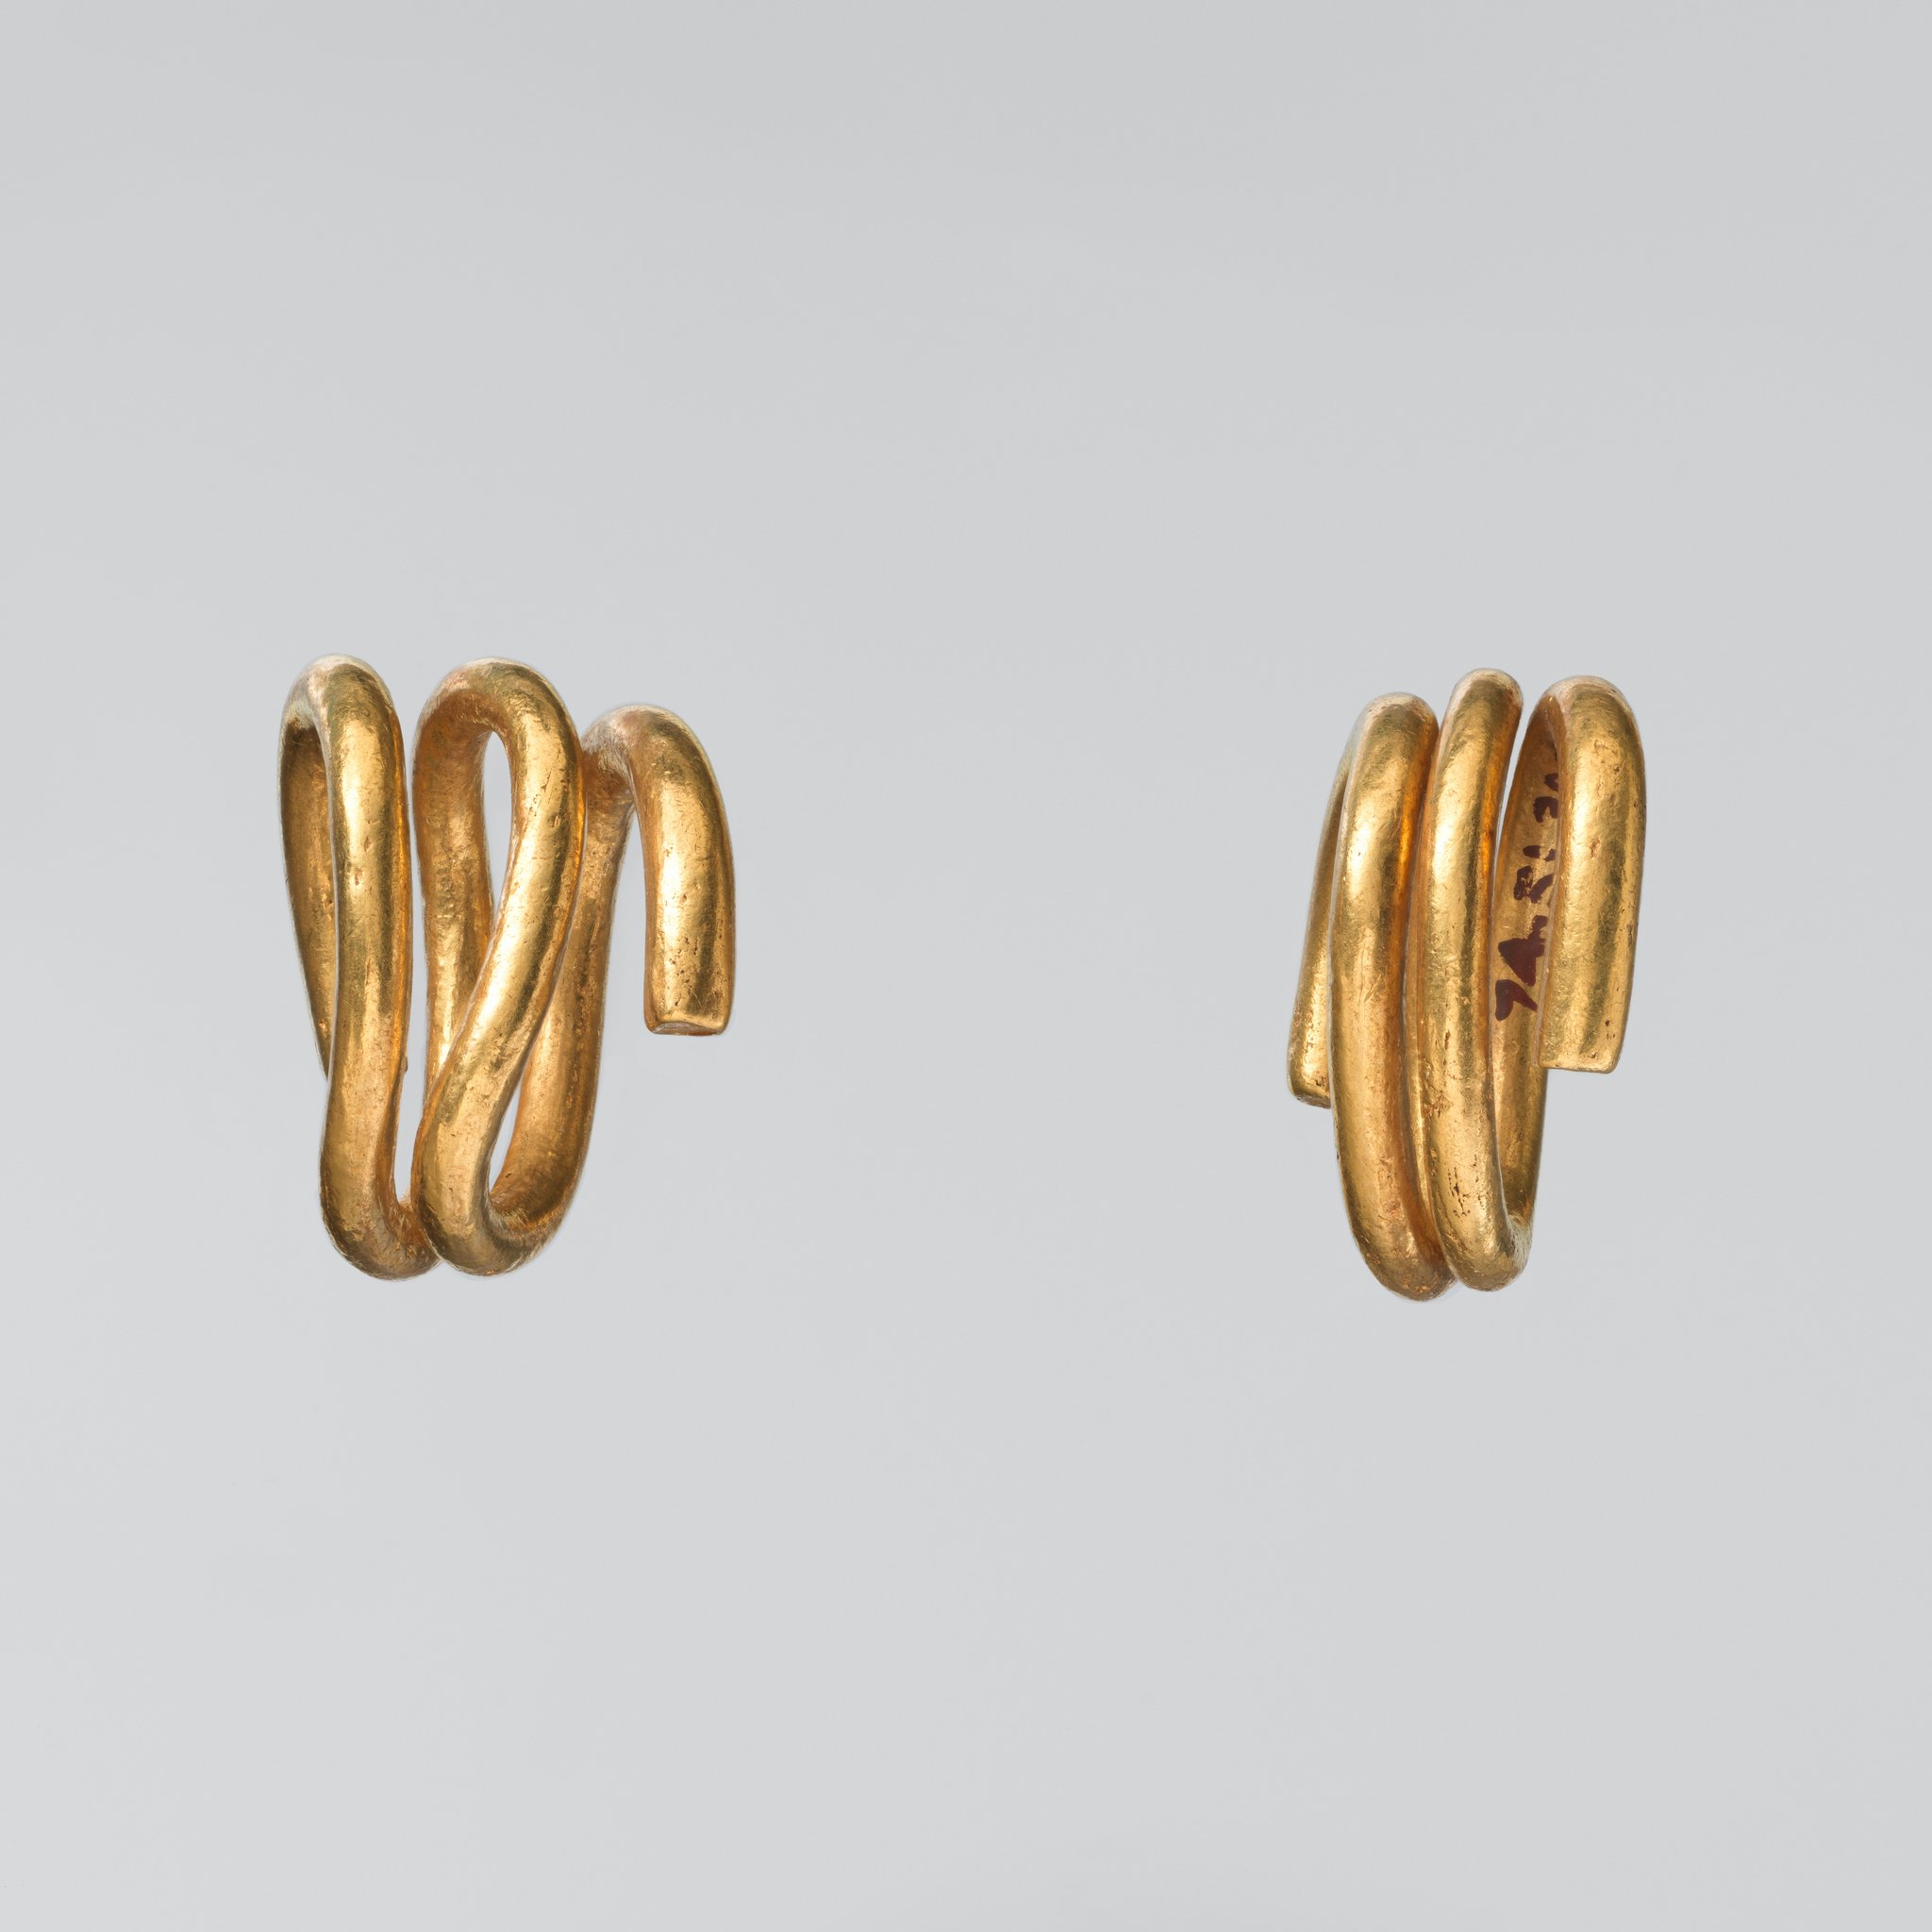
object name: earring or spiral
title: Gold spiral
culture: cypriot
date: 1600-1100 BCE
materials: gold